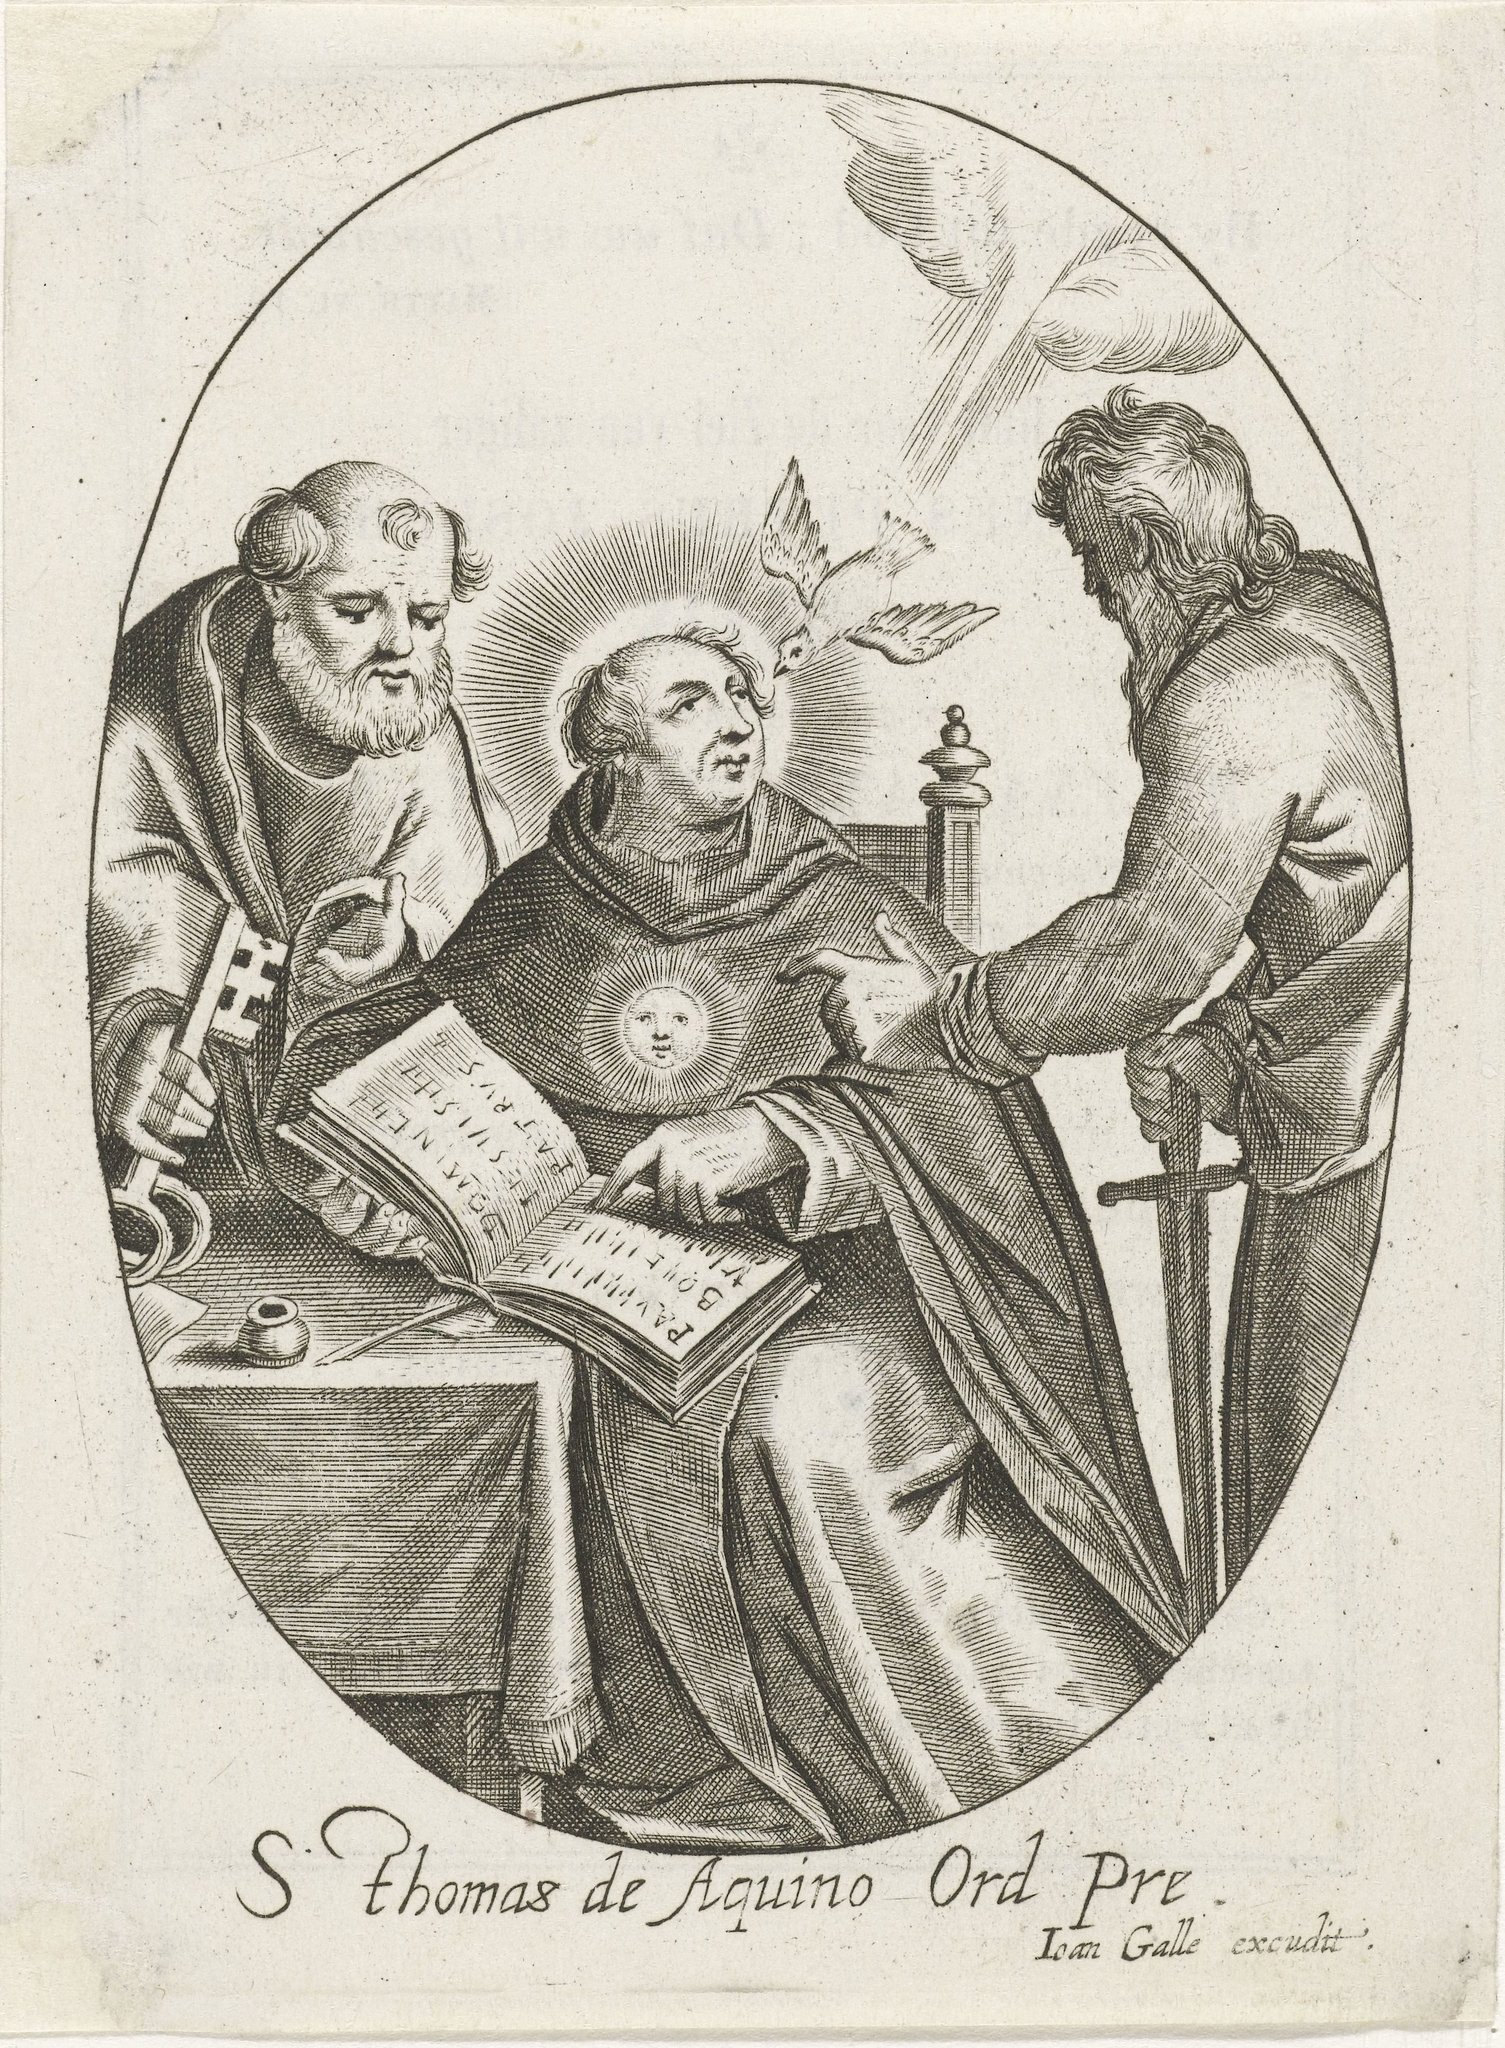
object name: prayer card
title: H. Thomas van Aquino met Petrus en Paulus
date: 1626-1676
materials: paper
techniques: engraving, letterpress printing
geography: antwerp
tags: peter and paul appear to st. thomas aquinas in his study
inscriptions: collector's mark: Lugt 2228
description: De heilige Thomas van Aquino zittend aan tafel in een studeervertrek, in gesprek met de heiligen Petrus en Paulus. Op het verso een bidprentje voor Joannes Petrus Josephus Gillis, overleden te Antwerpen in 1848.